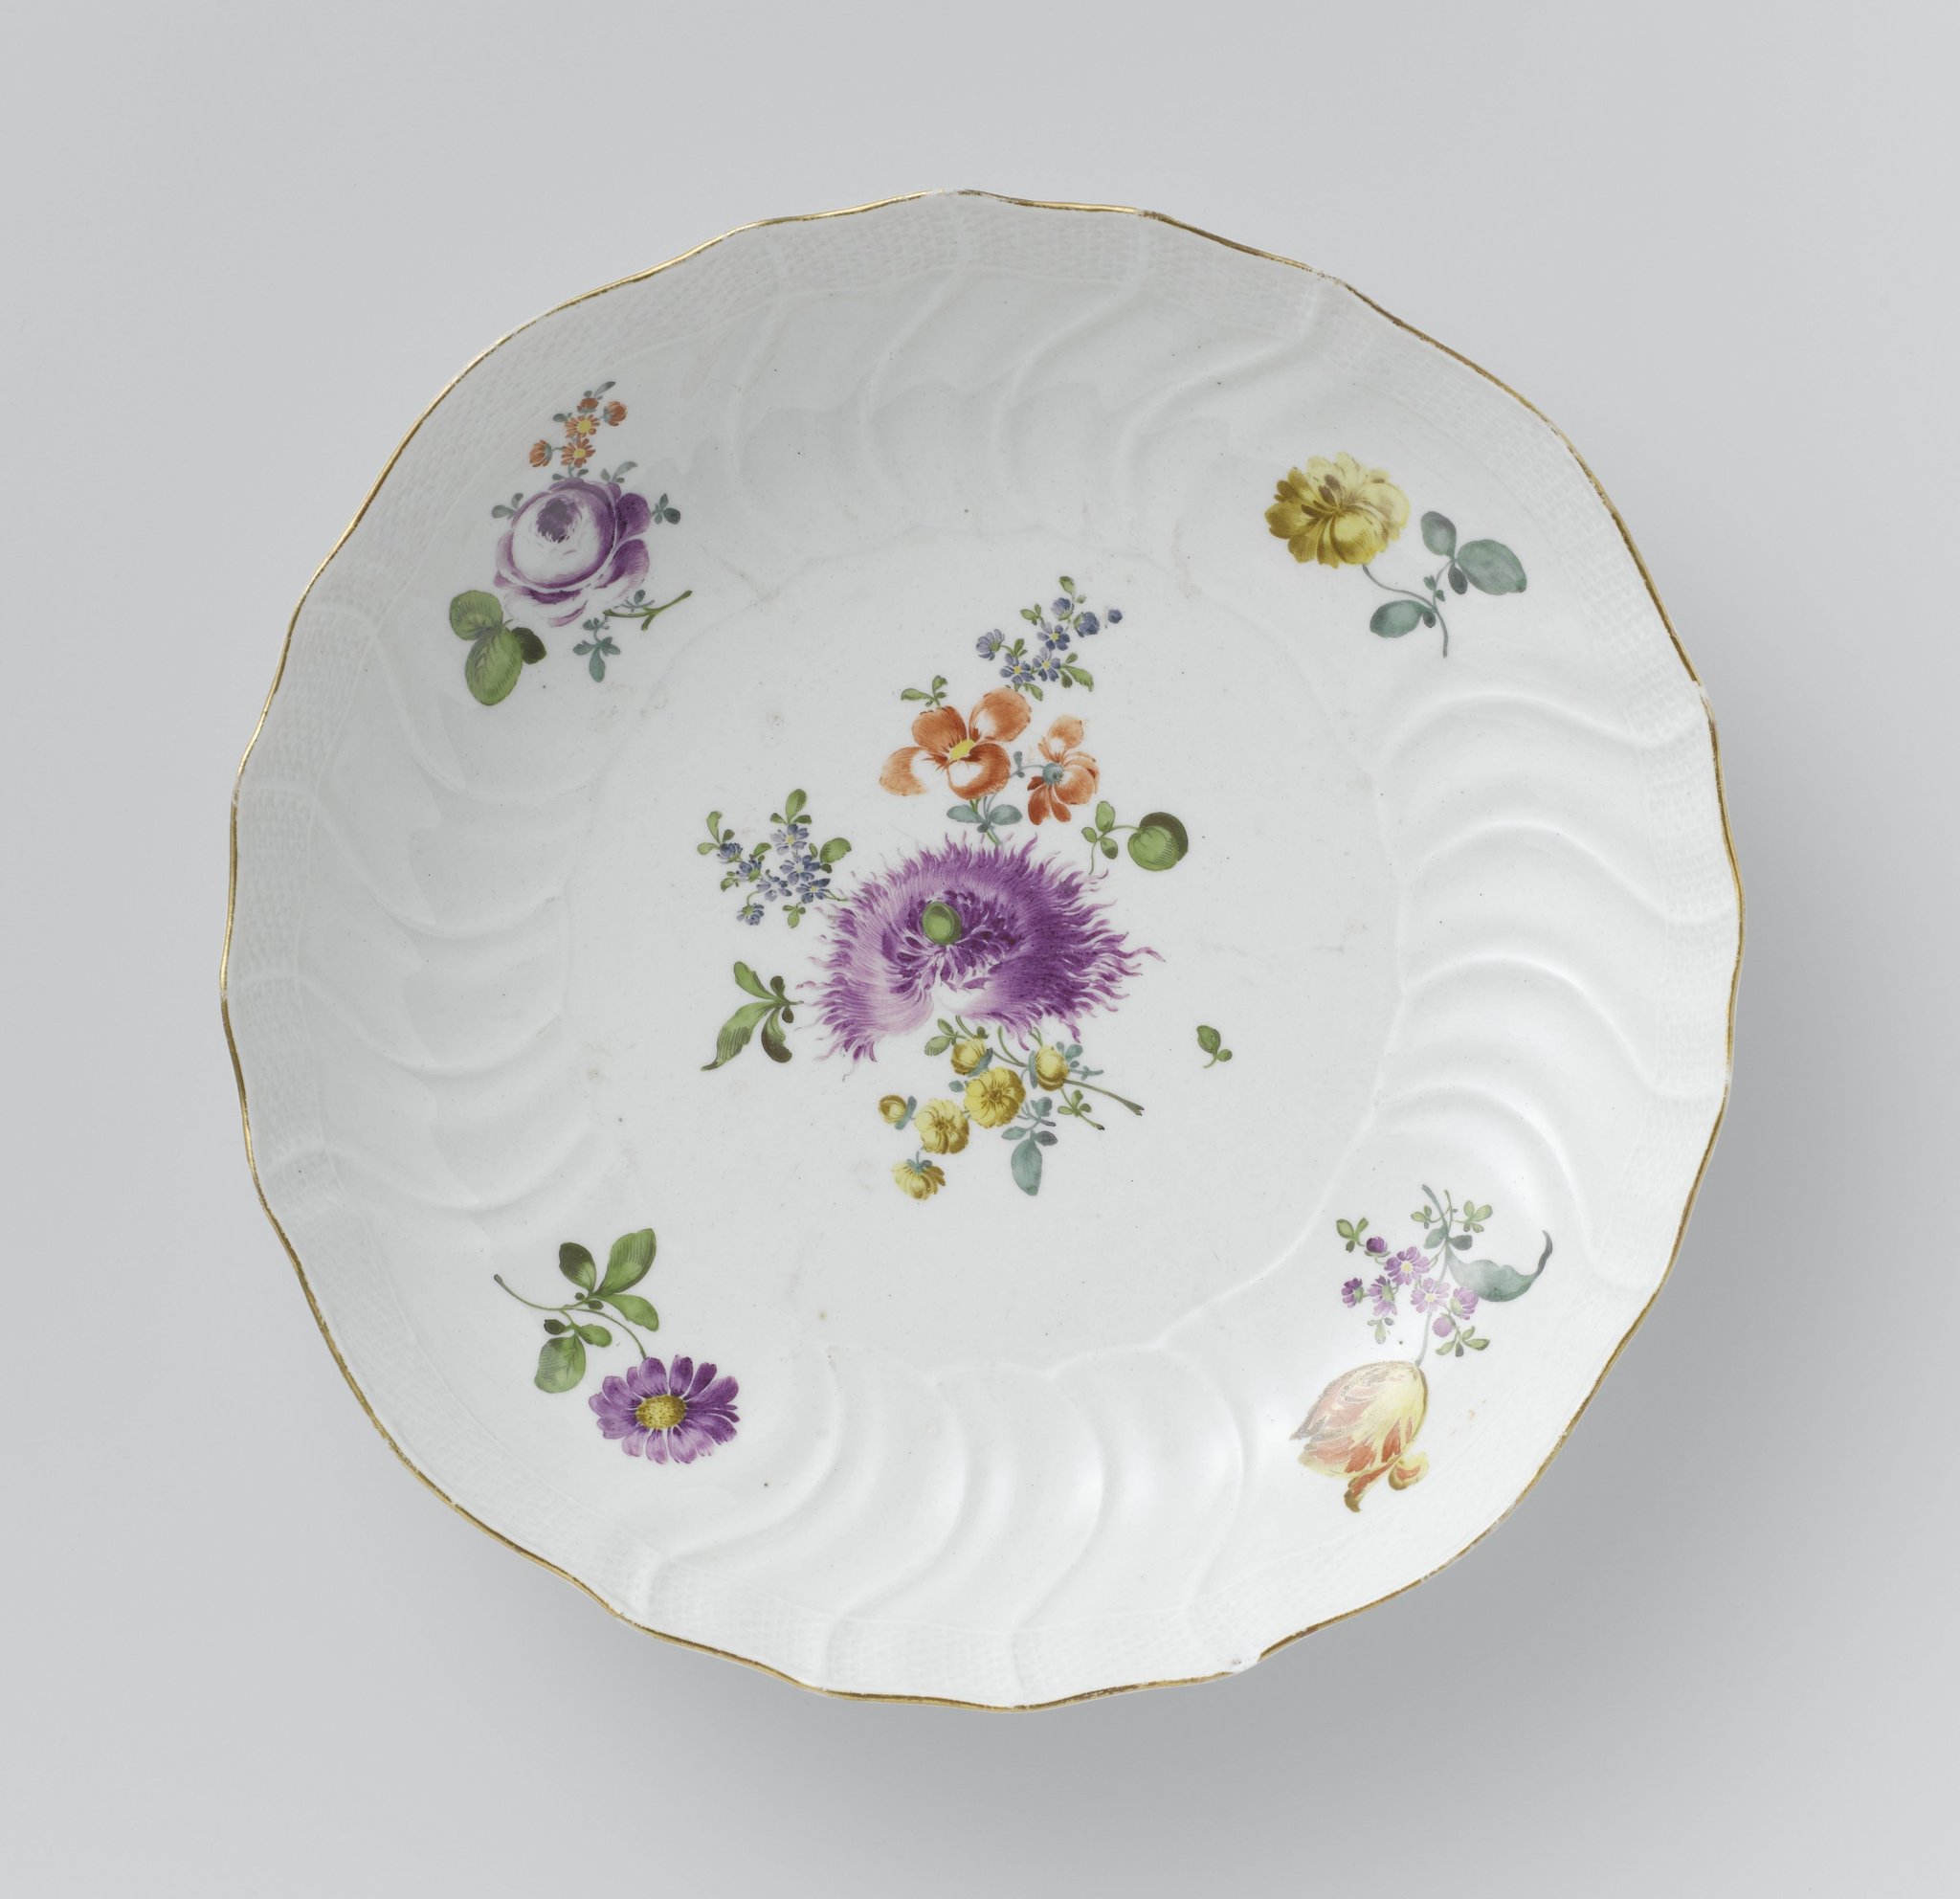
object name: eating drinking utensil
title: Schotel, veelkleurig beschilderd met Deutsche Blumen, insekten en vruchten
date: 1750-1760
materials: porcelain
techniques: painted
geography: meissen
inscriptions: factory mark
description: Ronde schotel van beschilderd porselein. De schotel is beschilderd met Deutsche Blumen, insekten en vruchten. De rand is in reliëf versierd met het Neuozier-patroon. De schotel is gemerkt en hoort bij een servies (BK-17474-1 t/m BK-17474-253).